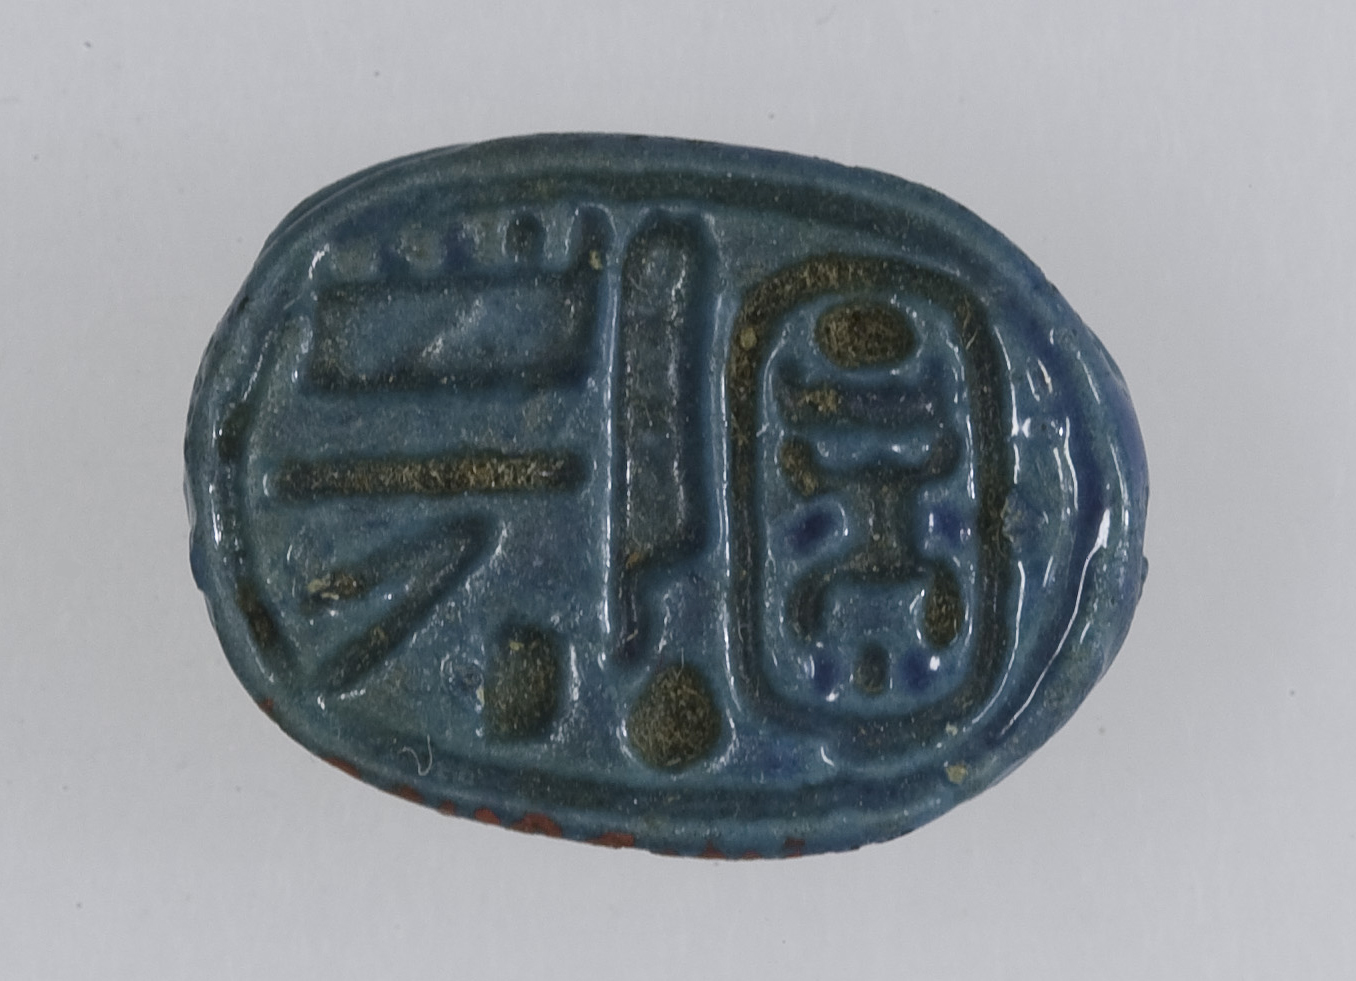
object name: scarab, thutmose iv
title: Scarab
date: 1400-1390 BCE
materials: stone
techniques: glazing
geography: upper egypt, thebes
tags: scarabs